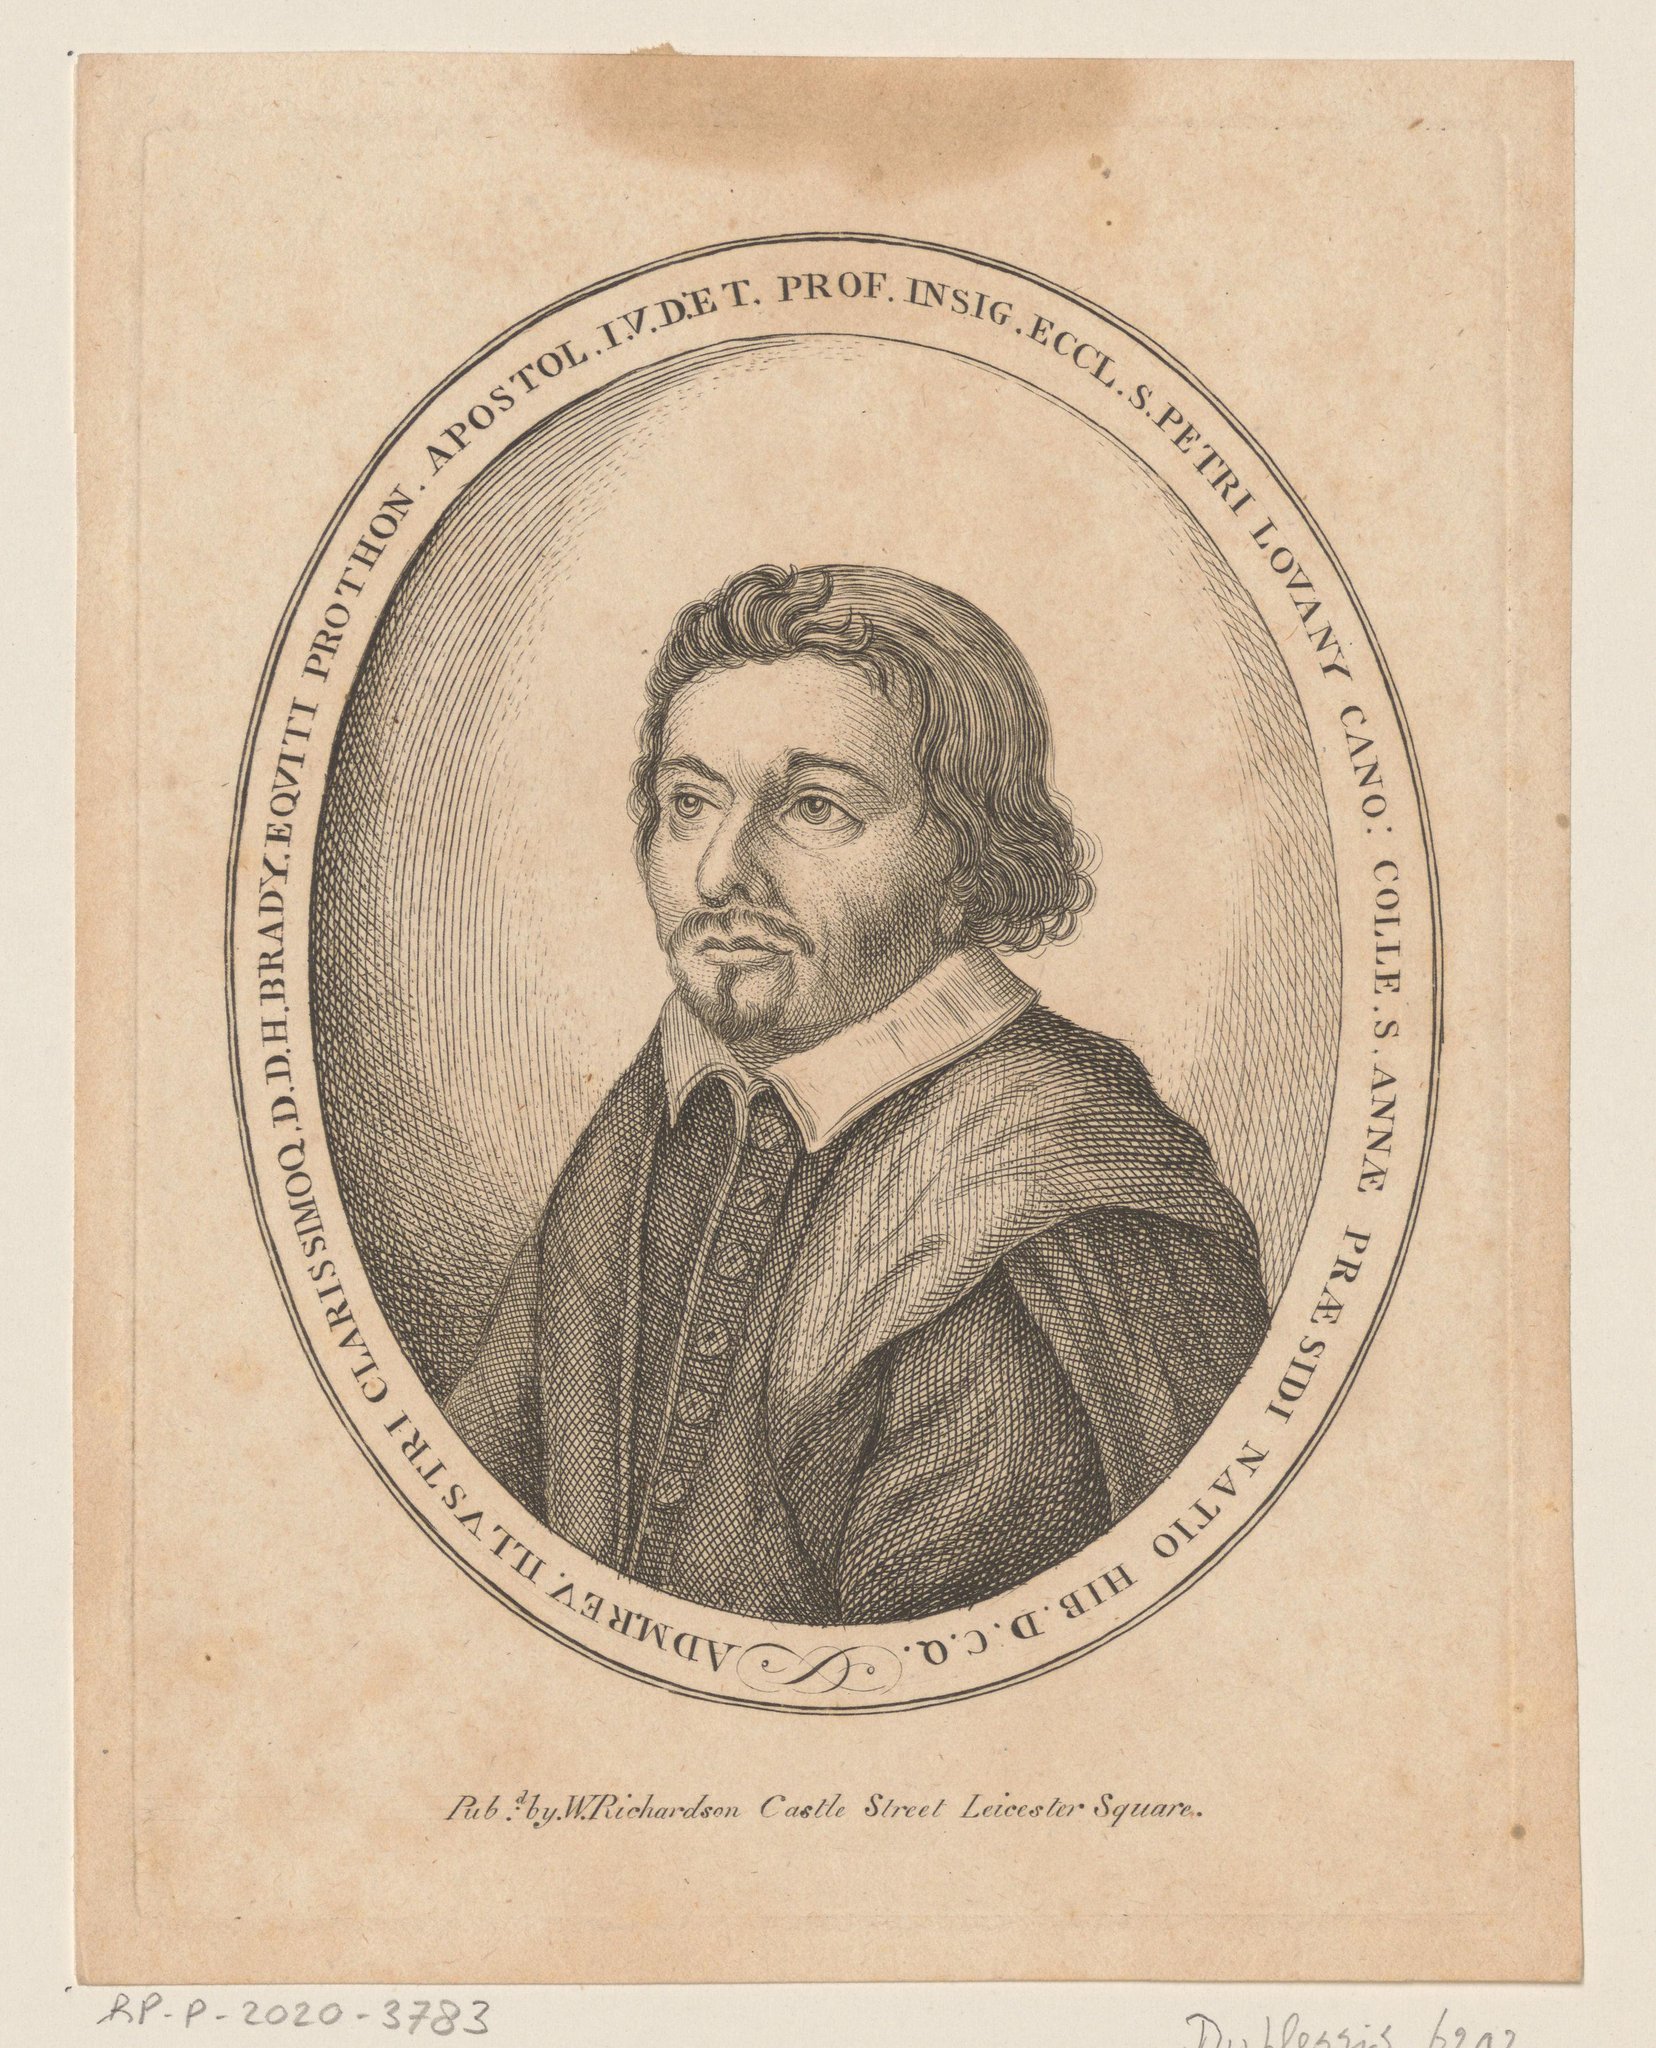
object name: print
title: Portret van Henry Brady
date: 1778-1812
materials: paper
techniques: engraving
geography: london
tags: historical persons